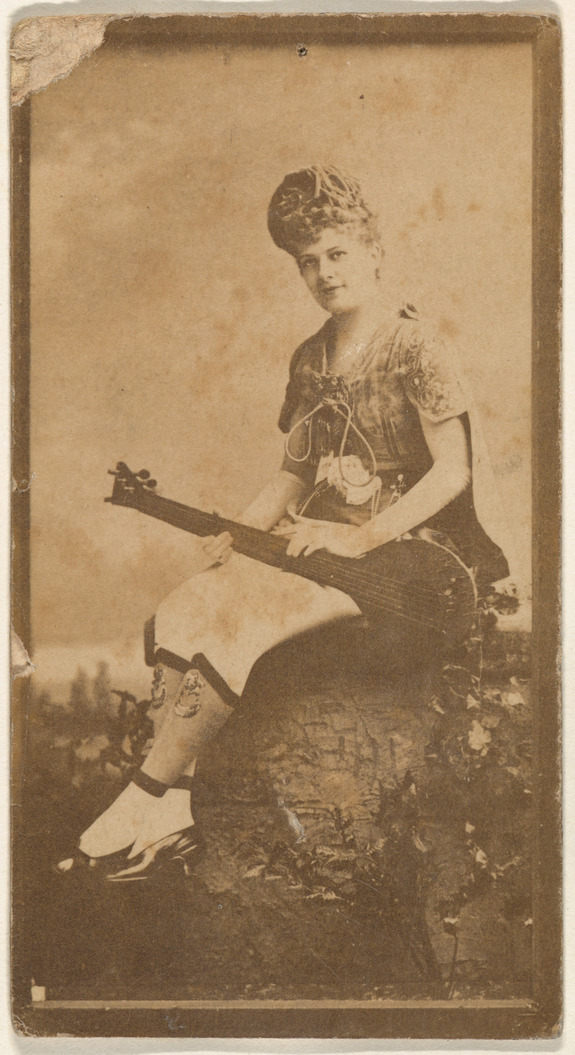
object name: photograph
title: Actress with mandolin, from the Actresses series (N668)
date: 1888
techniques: albumen silver print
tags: portraits,women,mandolins,actresses